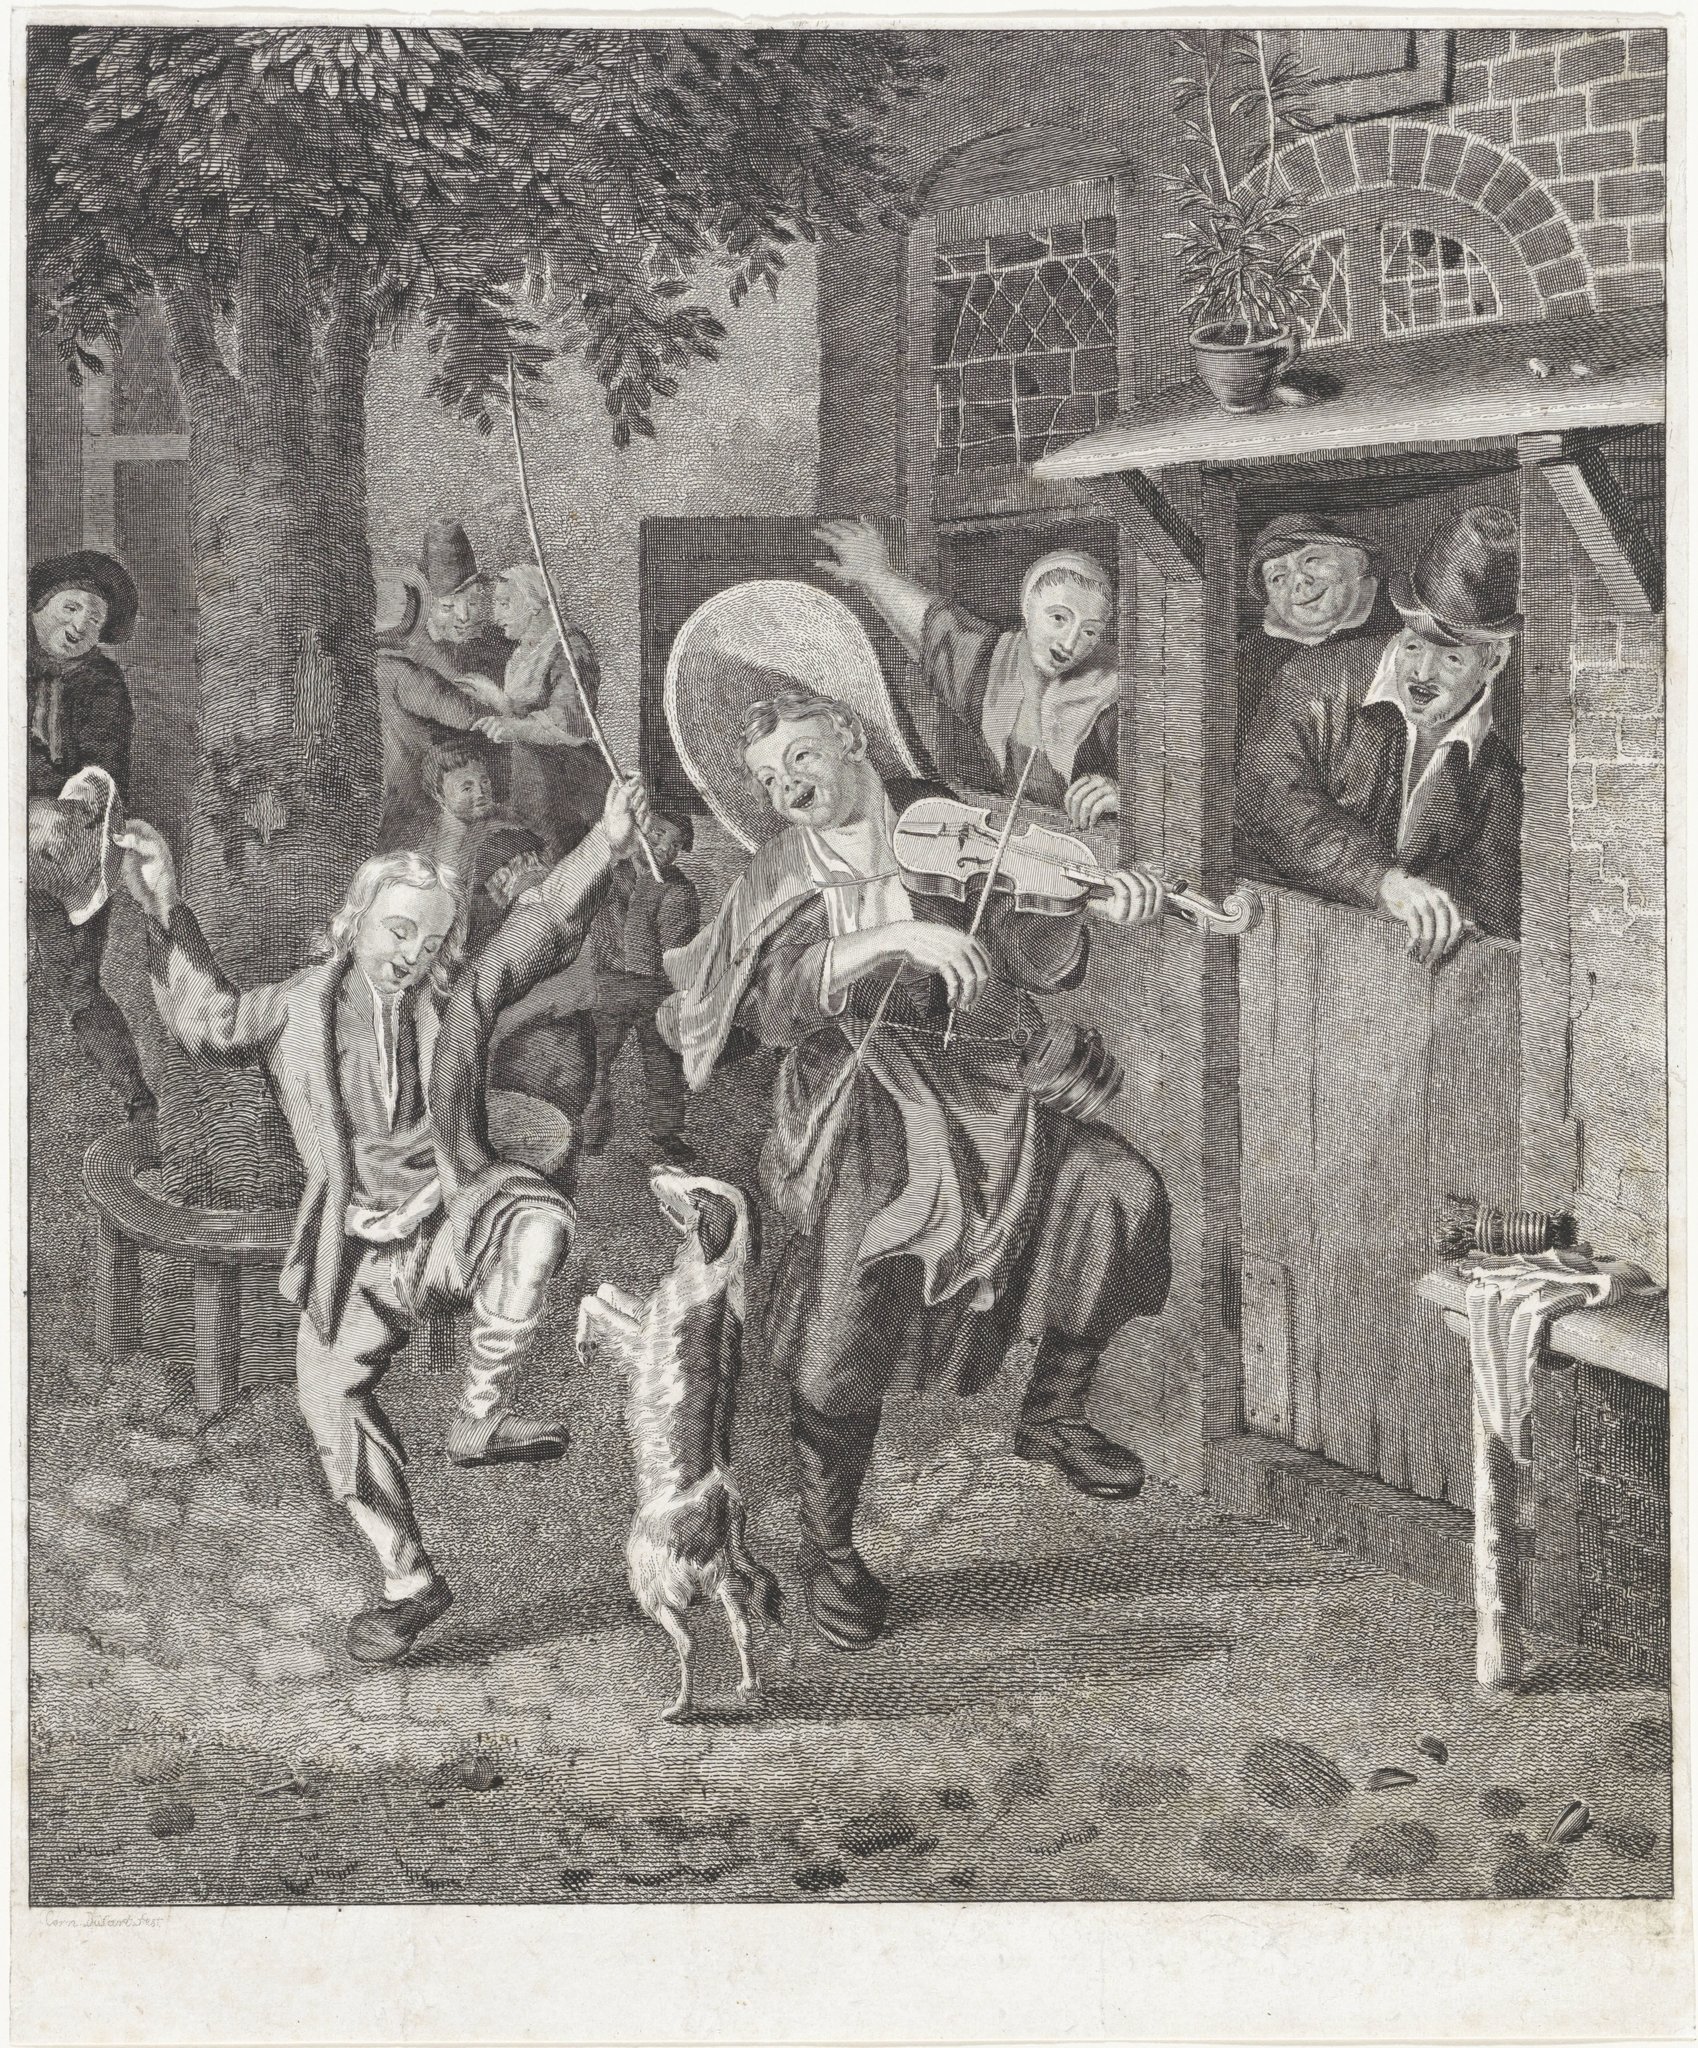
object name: print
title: Straatmuzikanten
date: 1830-1887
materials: paper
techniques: engraving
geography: haarlem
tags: musician at work - cc - out of doors, violin, fiddle - cc - out of doors, vocal music, singing - cc - out of doors, village (+ city(-scape) with figures, staffage), dog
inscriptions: collector's mark: Lugt 2228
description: Straatmuzikanten in een dorp. Voor een herberg speelt een vrouw op een viool en danst met een jongen en een hond. Kinderen, omstanders en herbergbezoekers kijken toe. Links enkele kippen.